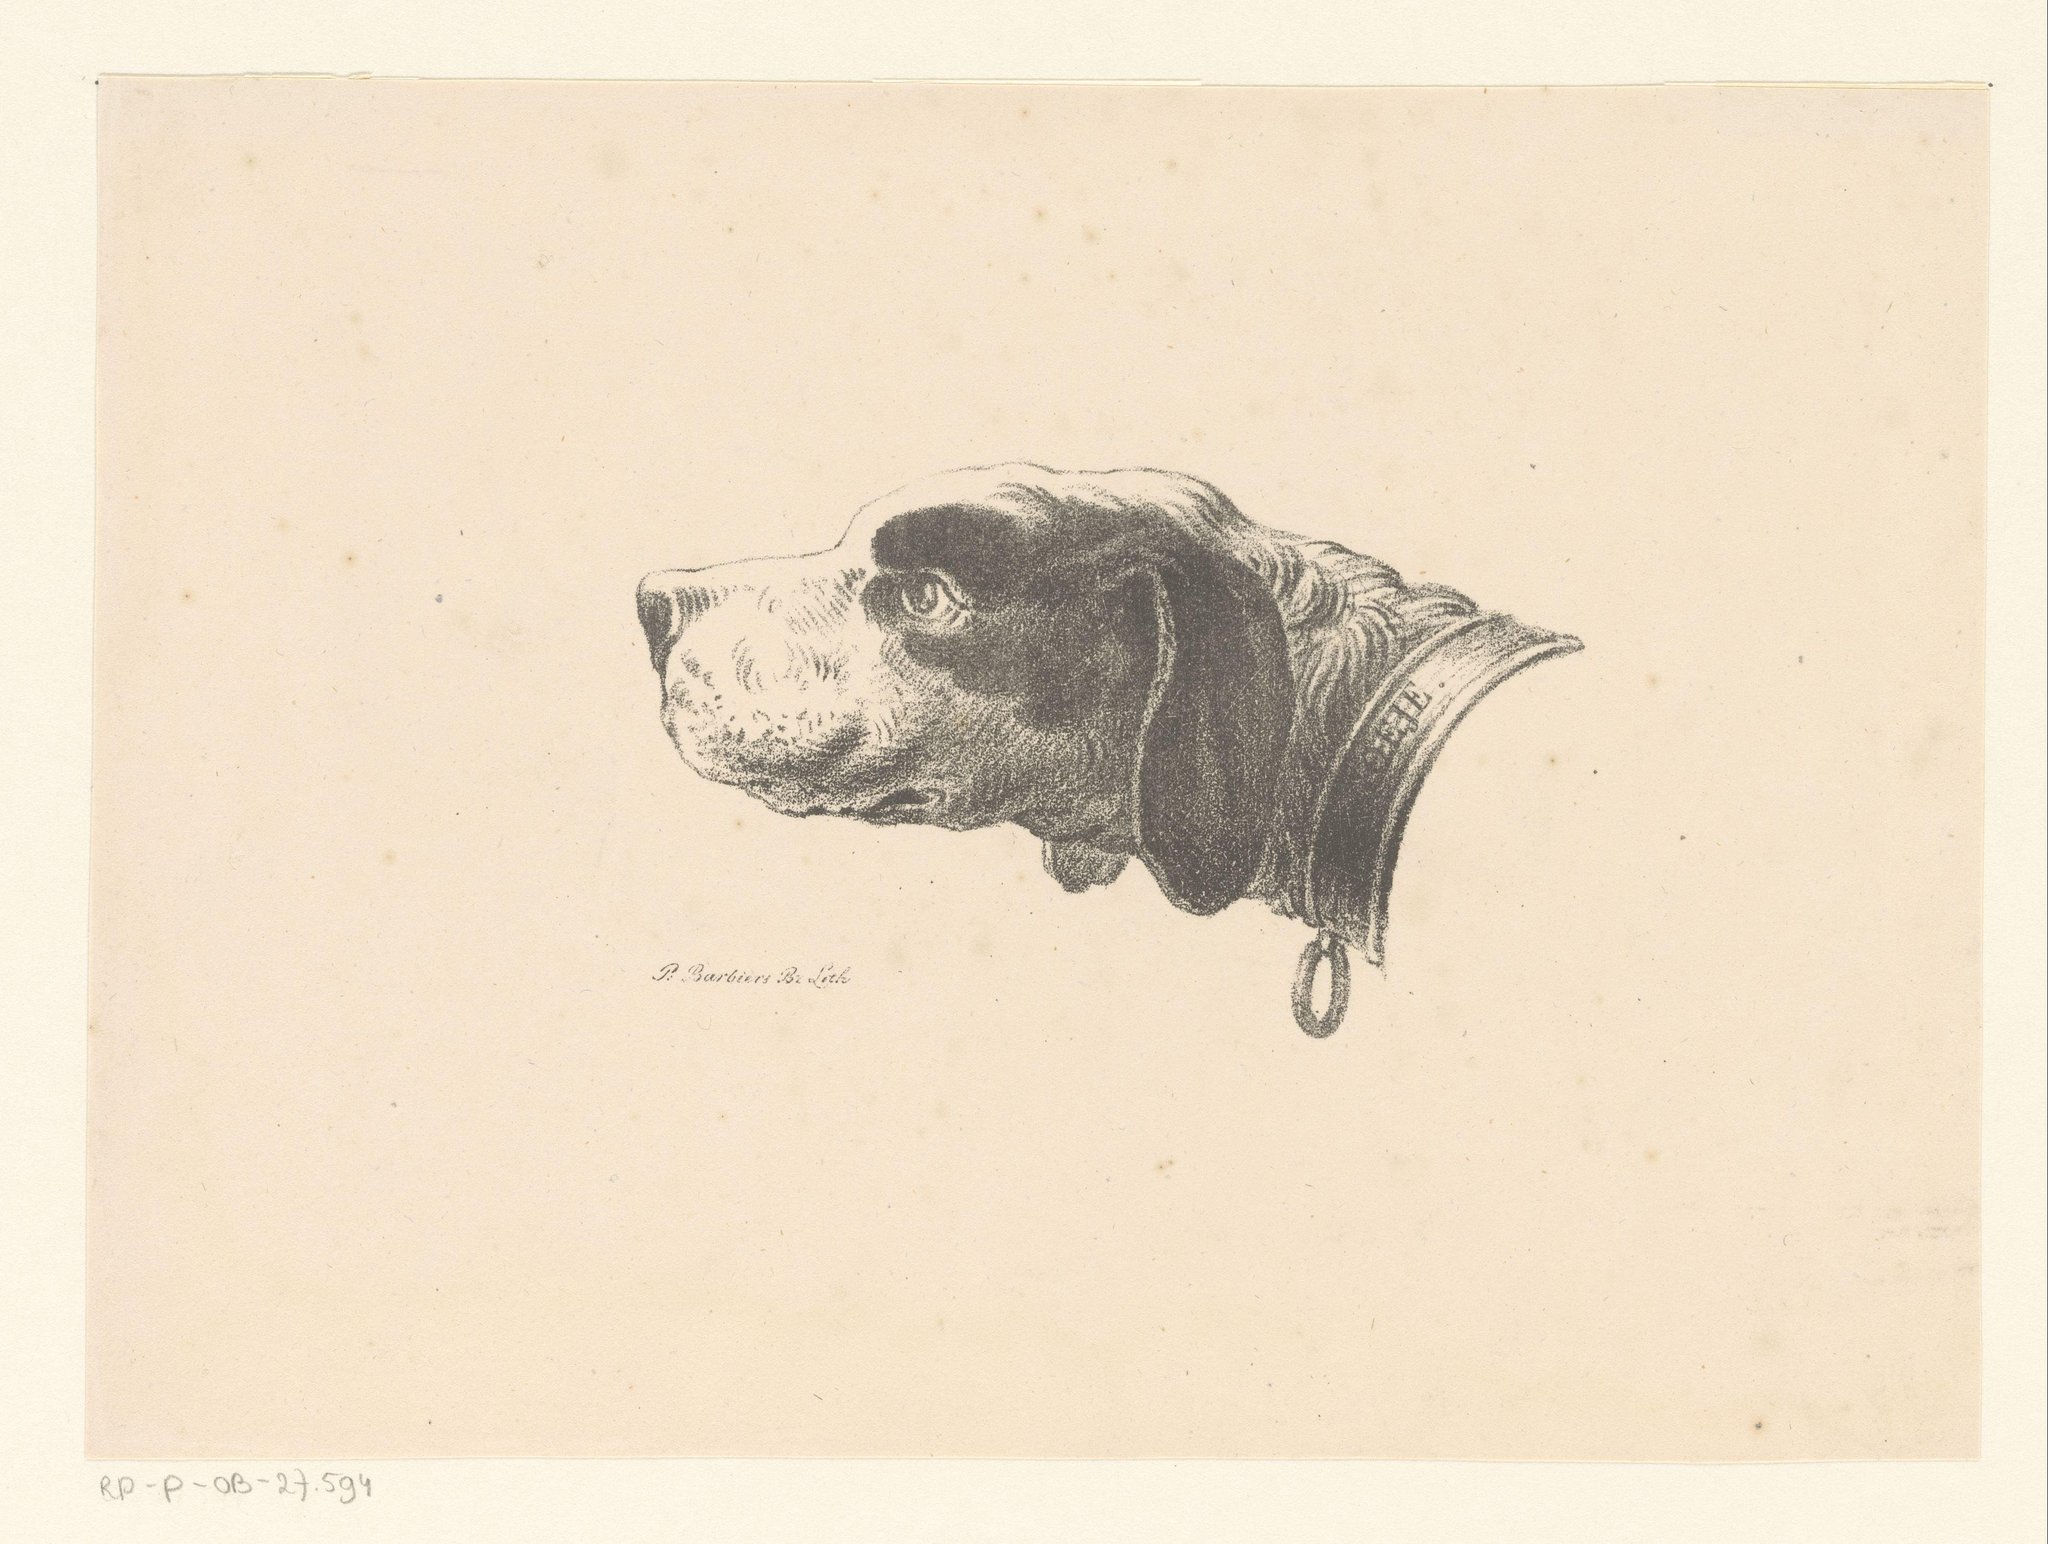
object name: print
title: Hondenkop met halsband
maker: pieter bartholomeusz. barbiers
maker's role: draughtsman, print maker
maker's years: 1772-1837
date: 1809-1837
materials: paper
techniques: lithograph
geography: haarlem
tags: dog (+ head of an animal), collar (of a dog)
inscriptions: collector's mark: Lugt 2228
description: Het woord op de halsband zou kunnen verwijzen naar P. de Goeie. Hij was tekenaar, prentmaker en schoonzoon van Pieter Barbiers Bzn.